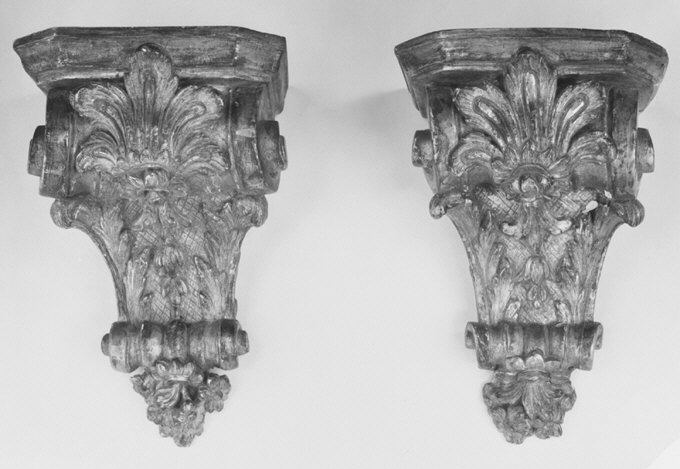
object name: wall bracket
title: Pair of wall brackets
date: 1720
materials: wood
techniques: carving, gilding